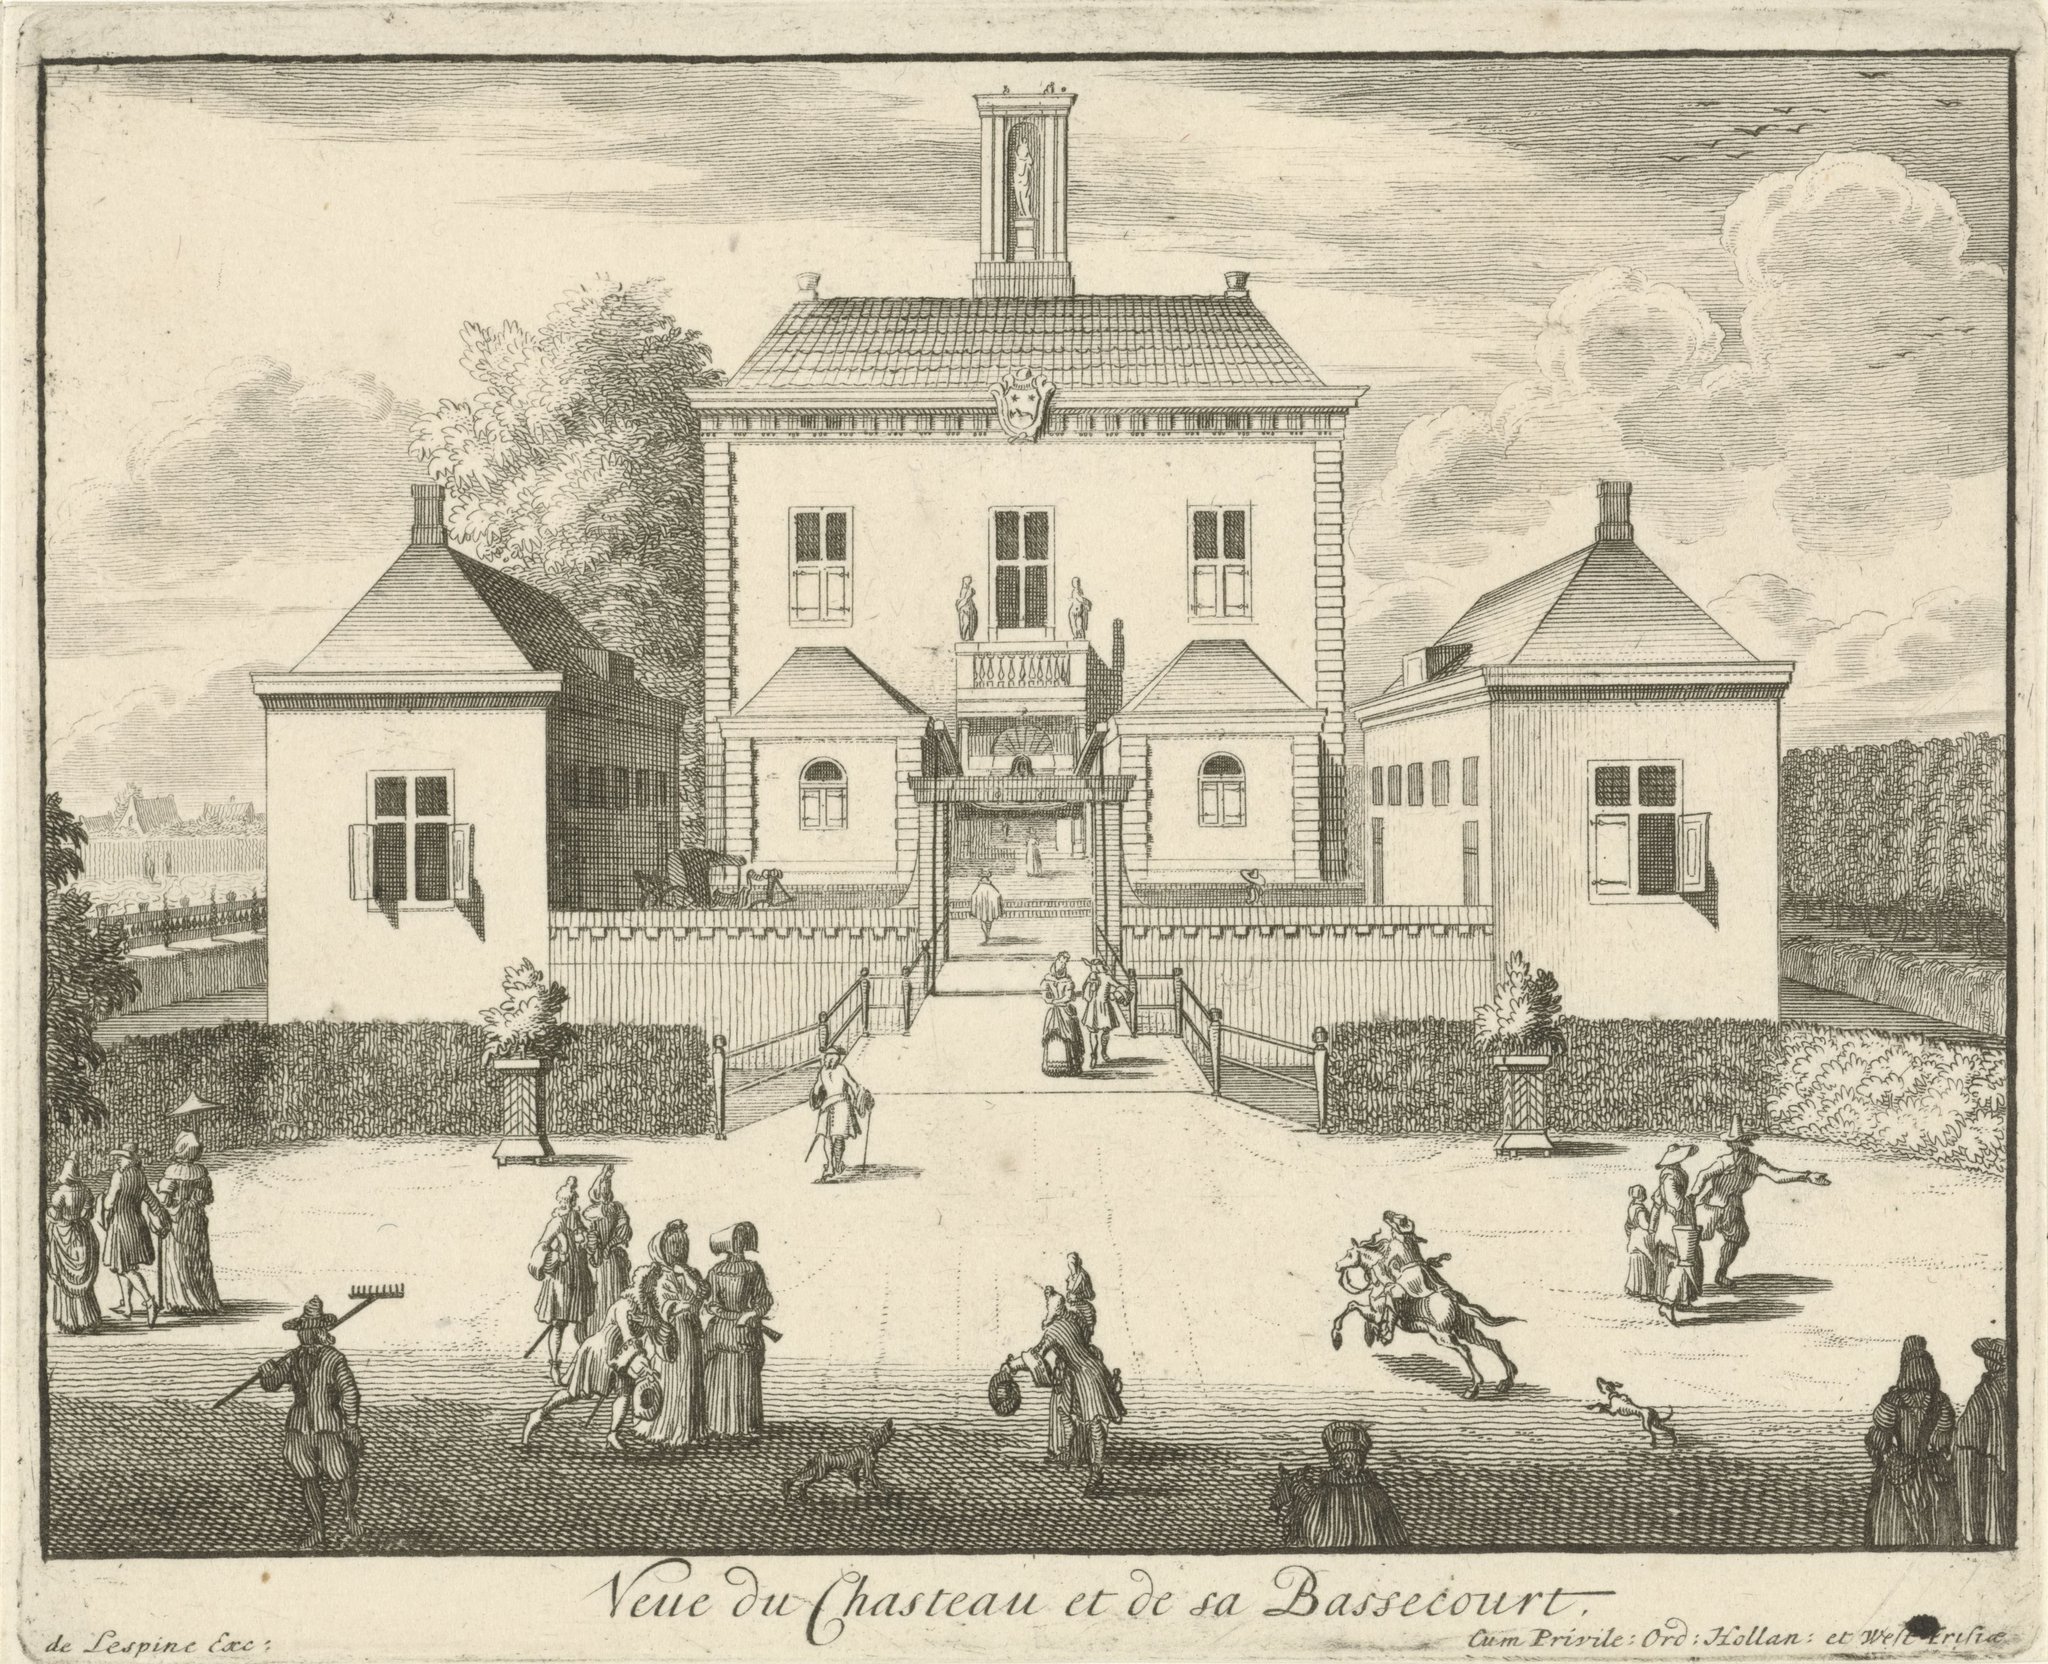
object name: print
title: Vooraanzicht van Kasteel Gunterstein, Breukelen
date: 1680-1696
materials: paper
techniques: engraving, etching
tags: magdalena poulle, castle, exterior ~ architectural design or model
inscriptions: collector's mark: Lugt 2228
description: Vooraanzicht van Kasteel Gunterstein te Breukelen. Boven de gevel het wapenschild van eigenaresse Magdalena Poulle. Voor de toegangsbrug een ruiter en andere figuren.